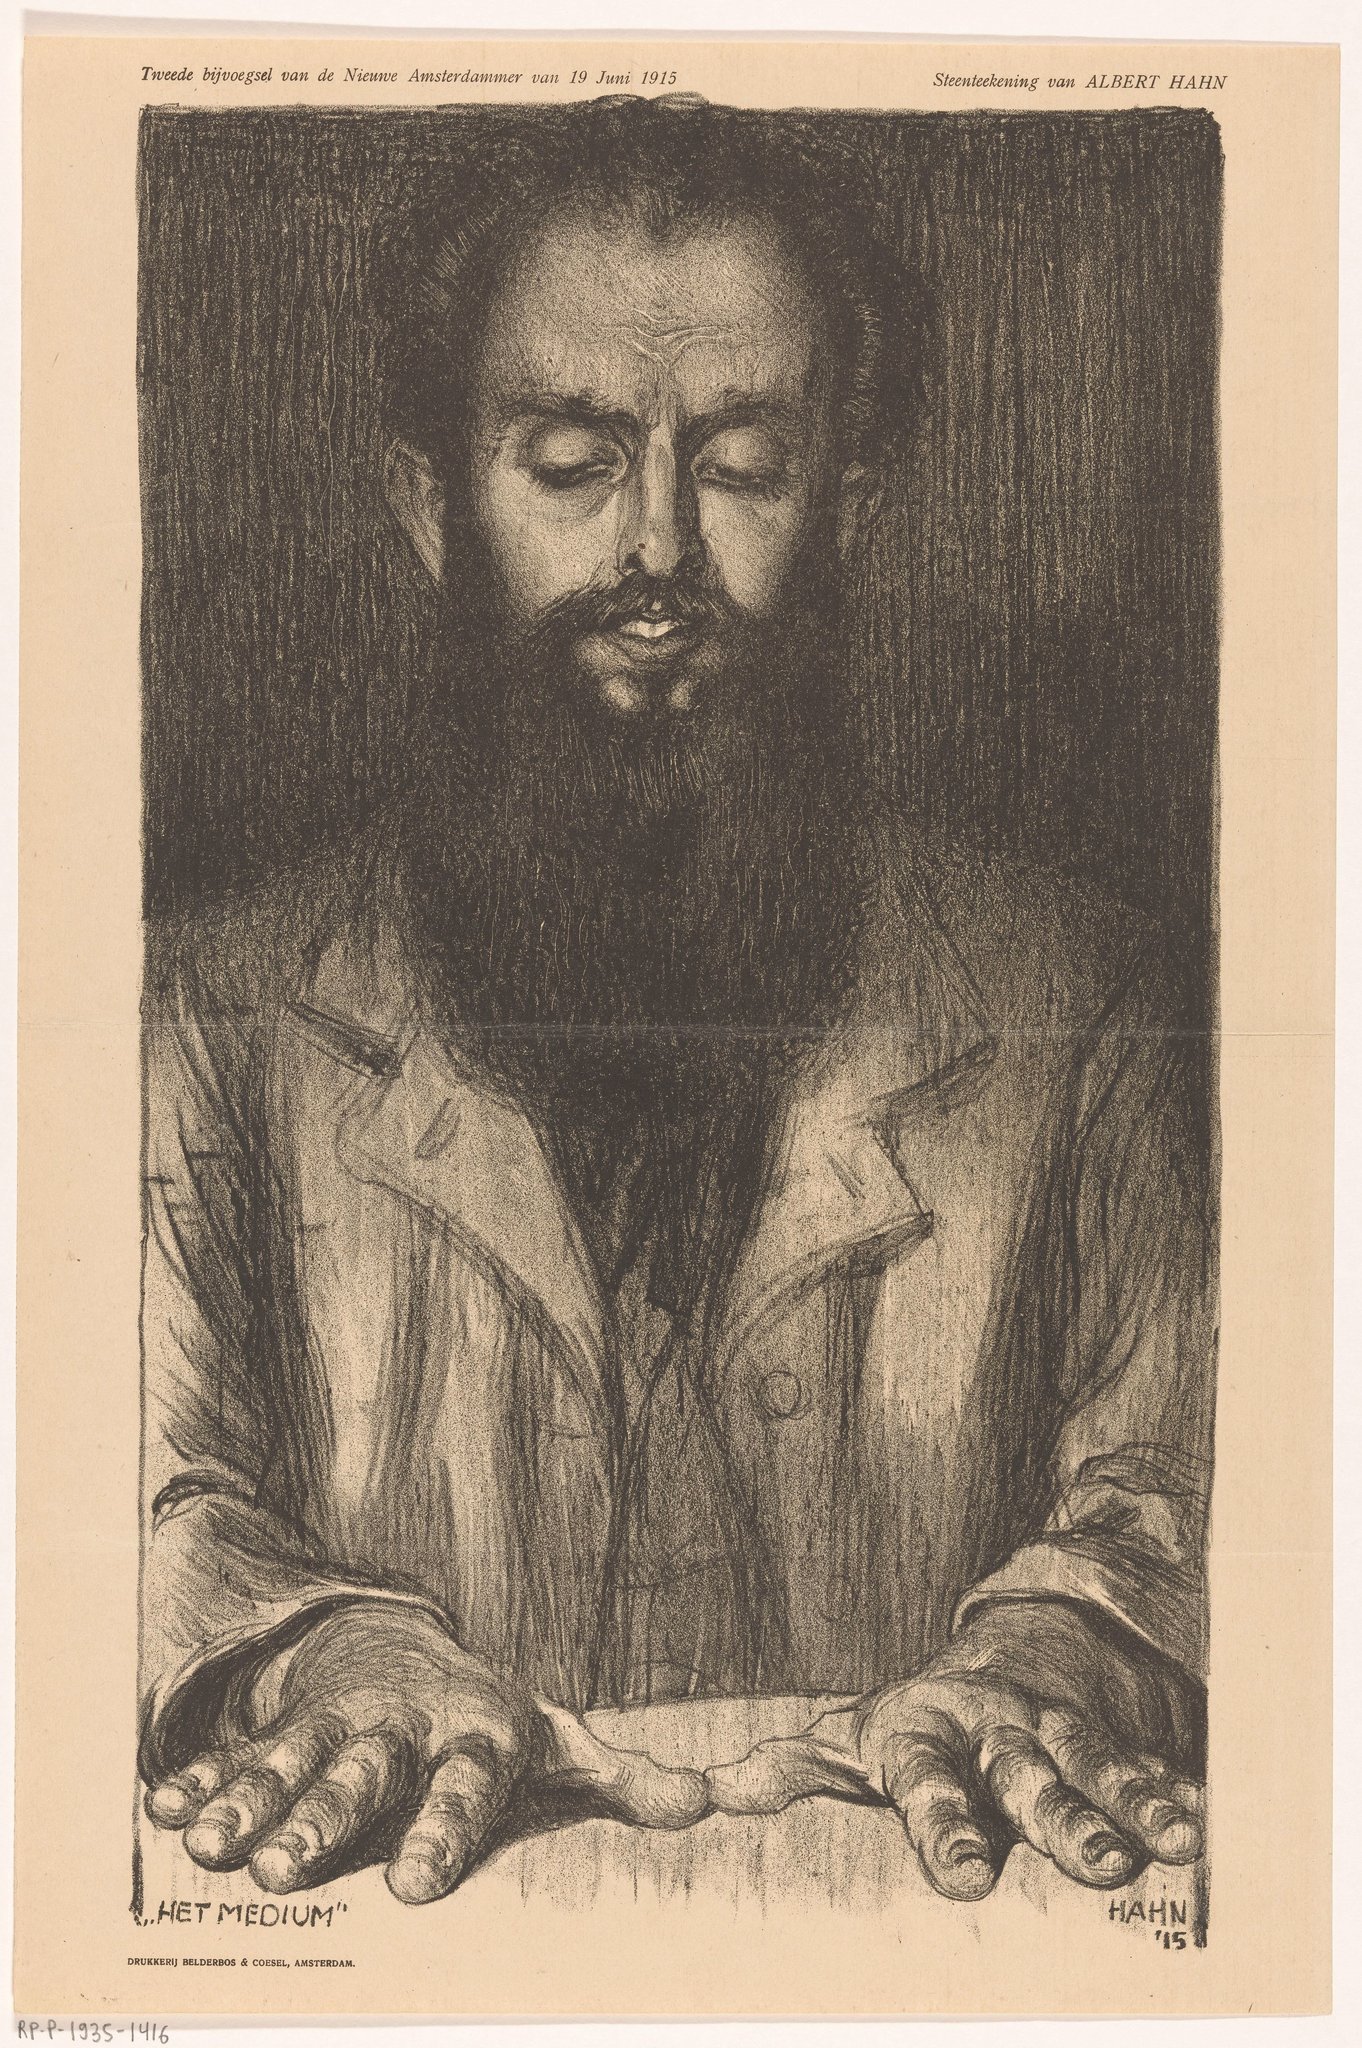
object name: print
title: Het medium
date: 1915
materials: paper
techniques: lithograph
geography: amsterdam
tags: medium ~ spiritualism, beard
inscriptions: collector's mark: Lugt 2166, collector's mark: Lugt 2760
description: Prent gebruikt voor: De nieuwe Amsterdammer, Onafhankelijk Nederlandsch weekblad. Amsterdam: Maatschappij voor Goede en Goedkope Lectuur, 19 juni 1915.